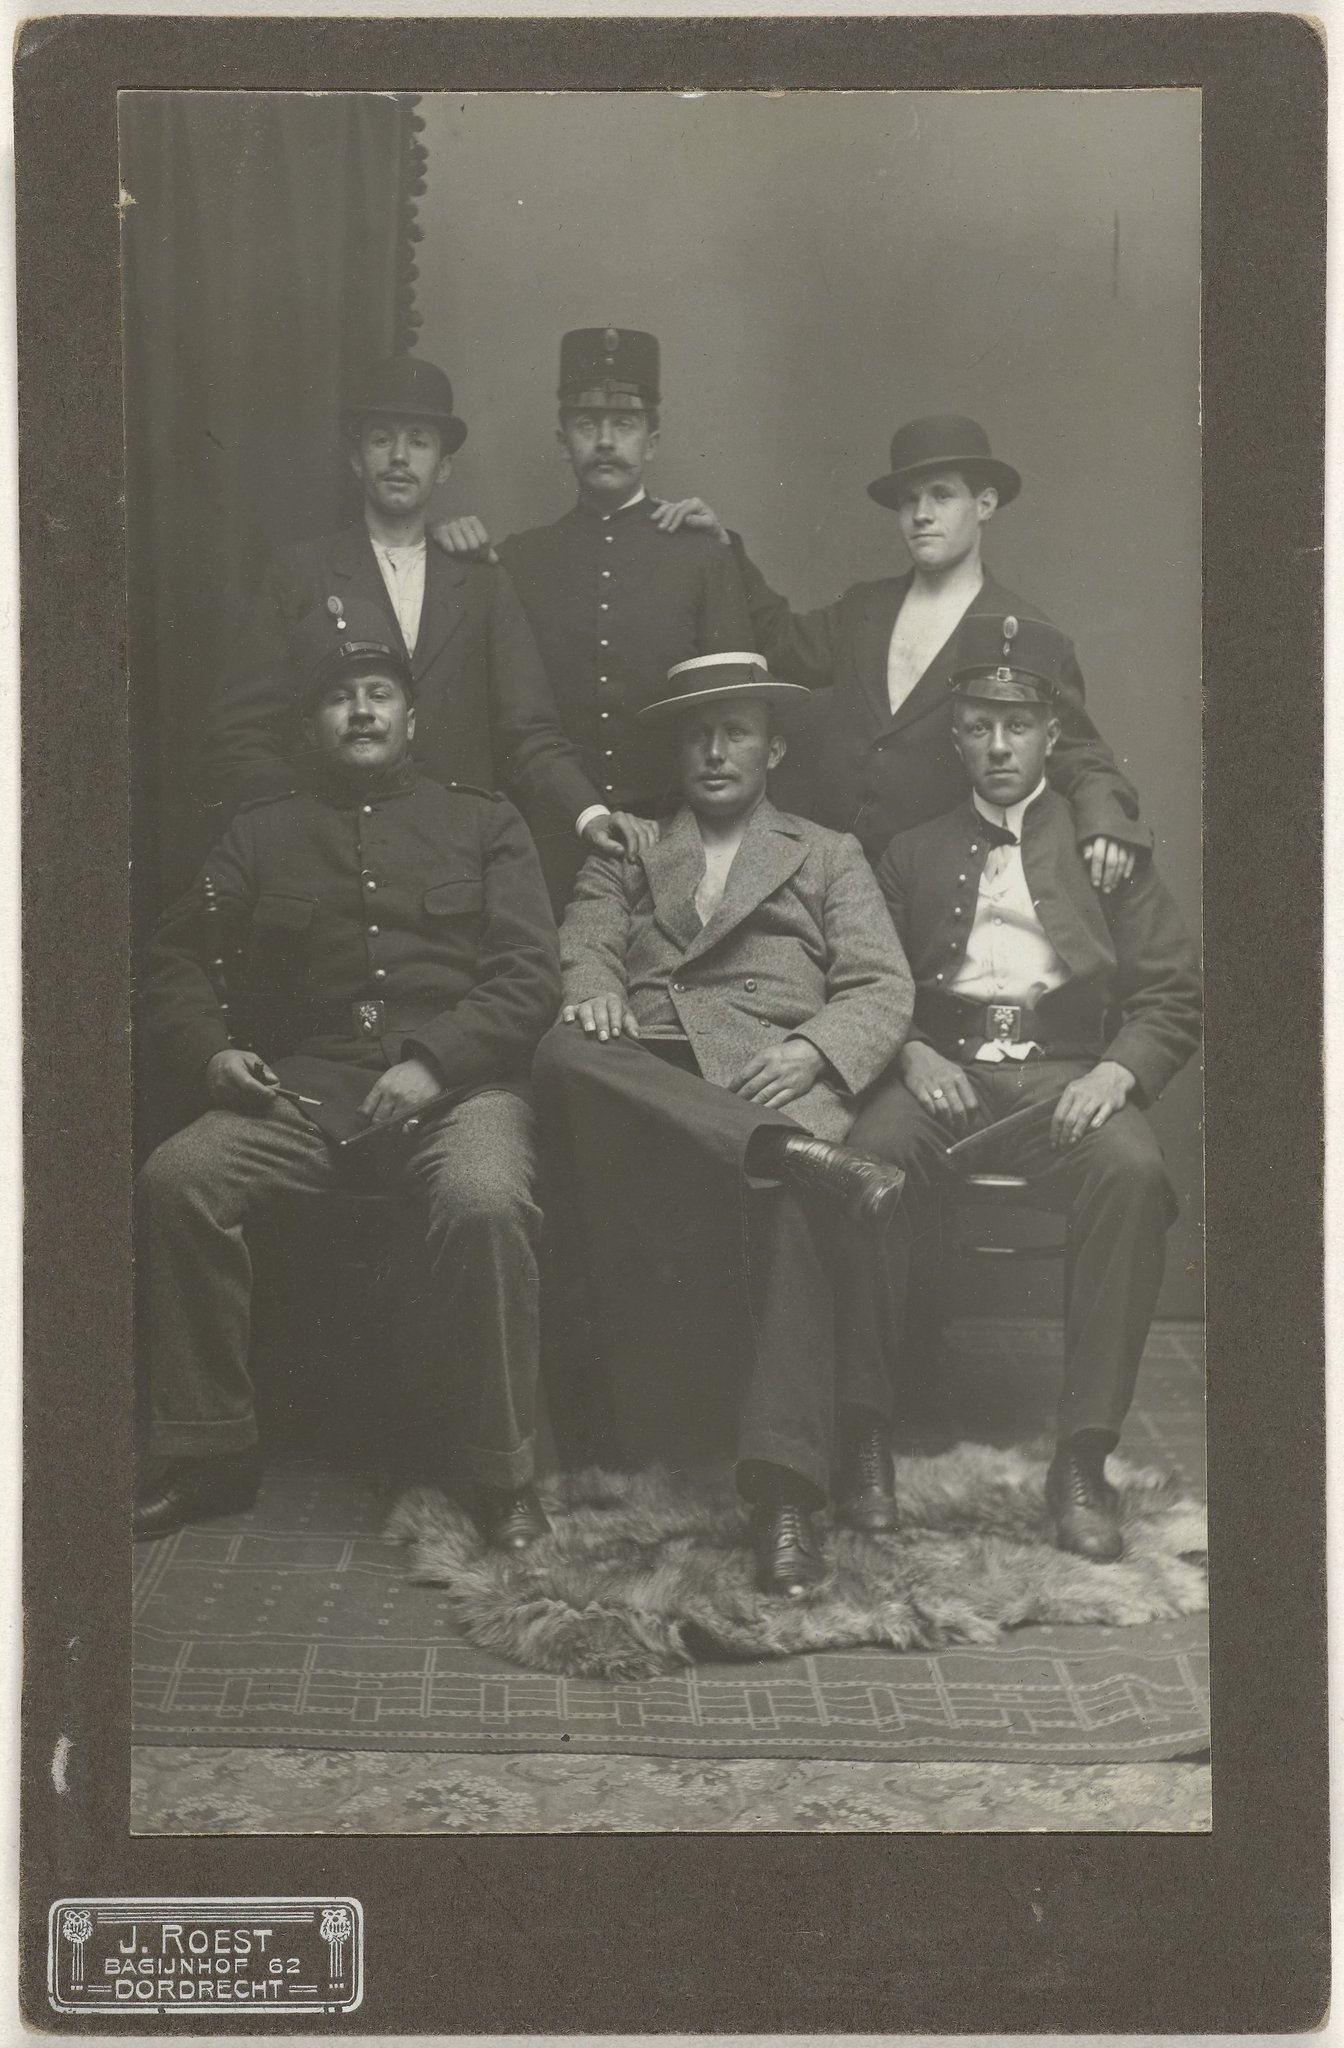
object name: cabinet photograph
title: Studioportret van een groep mannen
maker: j. roest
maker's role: fotograaf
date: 1890-1920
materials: cardboard, photographic support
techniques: matte daylight collodion silver print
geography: amsterdam